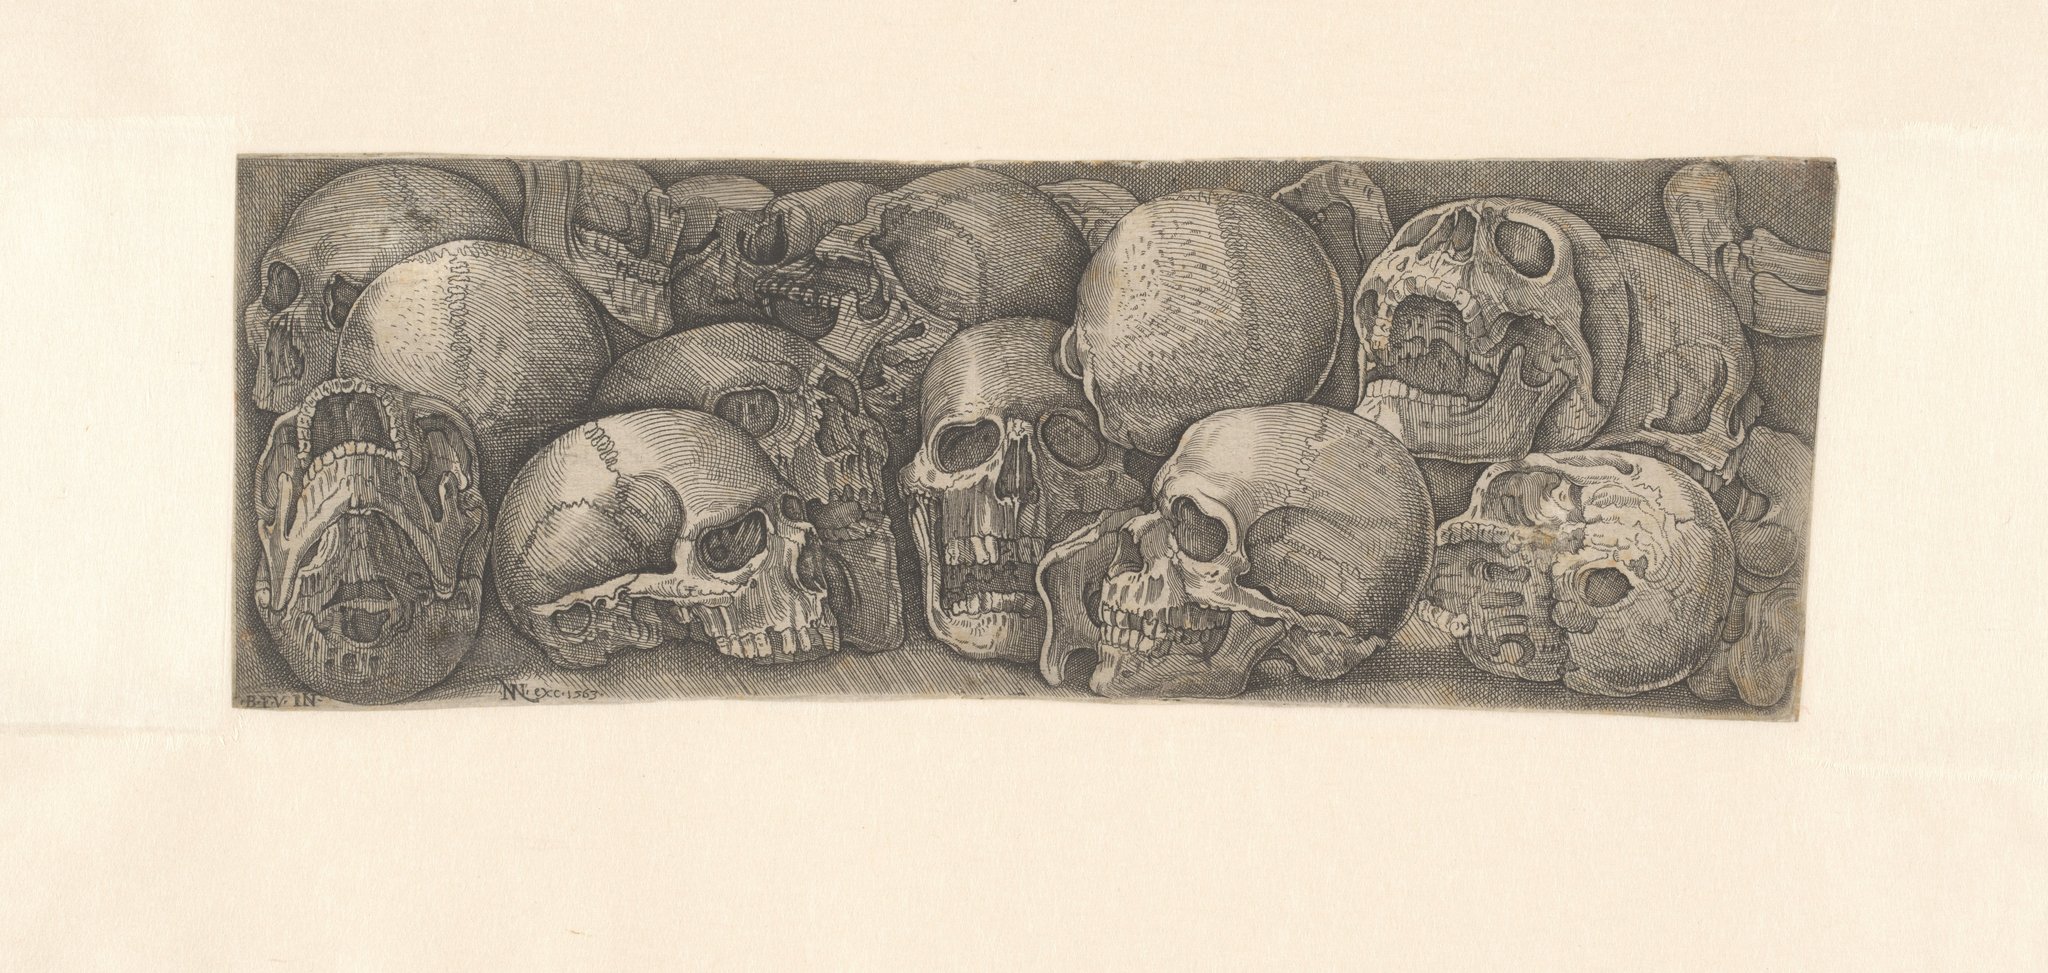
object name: print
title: Menselijke schedels, gezien vanuit verschillende hoeken en als fries gegroepeerd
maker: niccolò nelli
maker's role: print maker, publisher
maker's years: 1535-1585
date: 1530-1560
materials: paper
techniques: engraving, etching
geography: venice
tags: (human) skull, still life of related objects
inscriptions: collector's mark: Lugt 2760, collector's mark: Lugt 2228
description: Franco maakte meerdere studies van botten; zeven tekeningen uit deze reeks bevinden zich in de collectie van het Cleveland Museum of Art. Een achtste tekening, in privébezit, diende als voorbeeld voor deze prent.